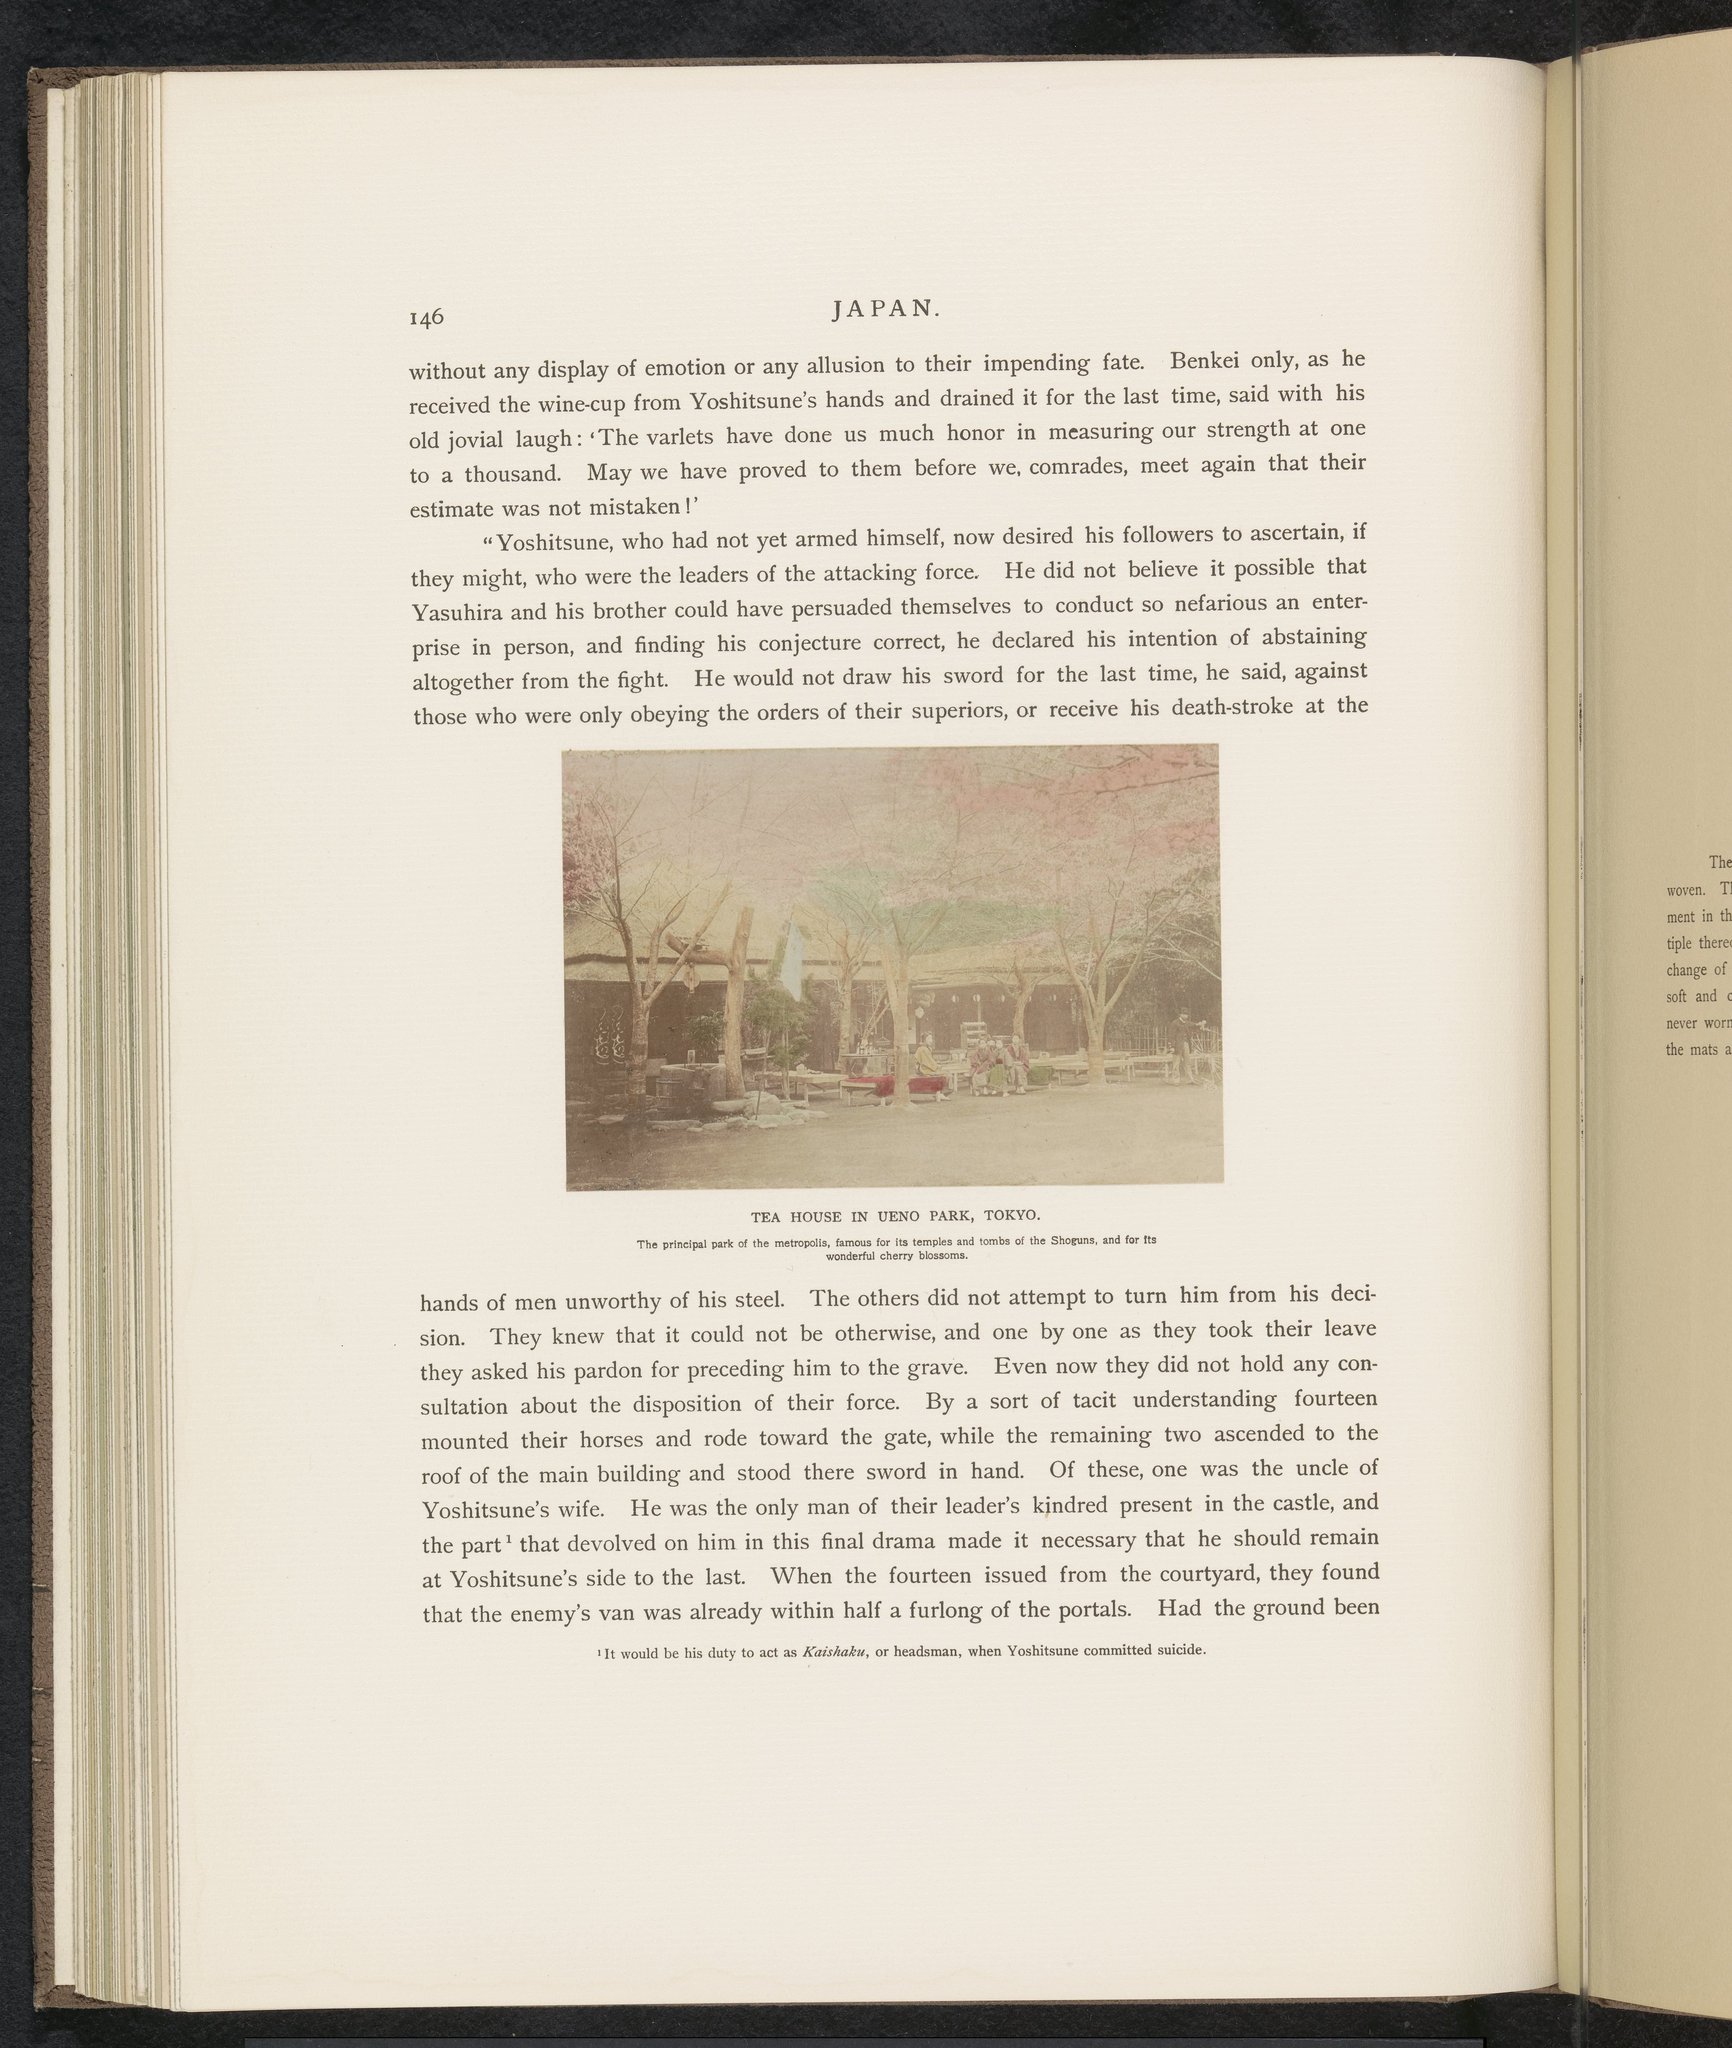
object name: page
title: Tea house in Ueno Park, Tokyo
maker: Anonymous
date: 1887-1897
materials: photographic support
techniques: albumen print, hand coloring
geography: japan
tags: tea garden, garden restaurant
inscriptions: inscription: ‘The principal park of the metropolis (...) wonderful cherry blossoms.’